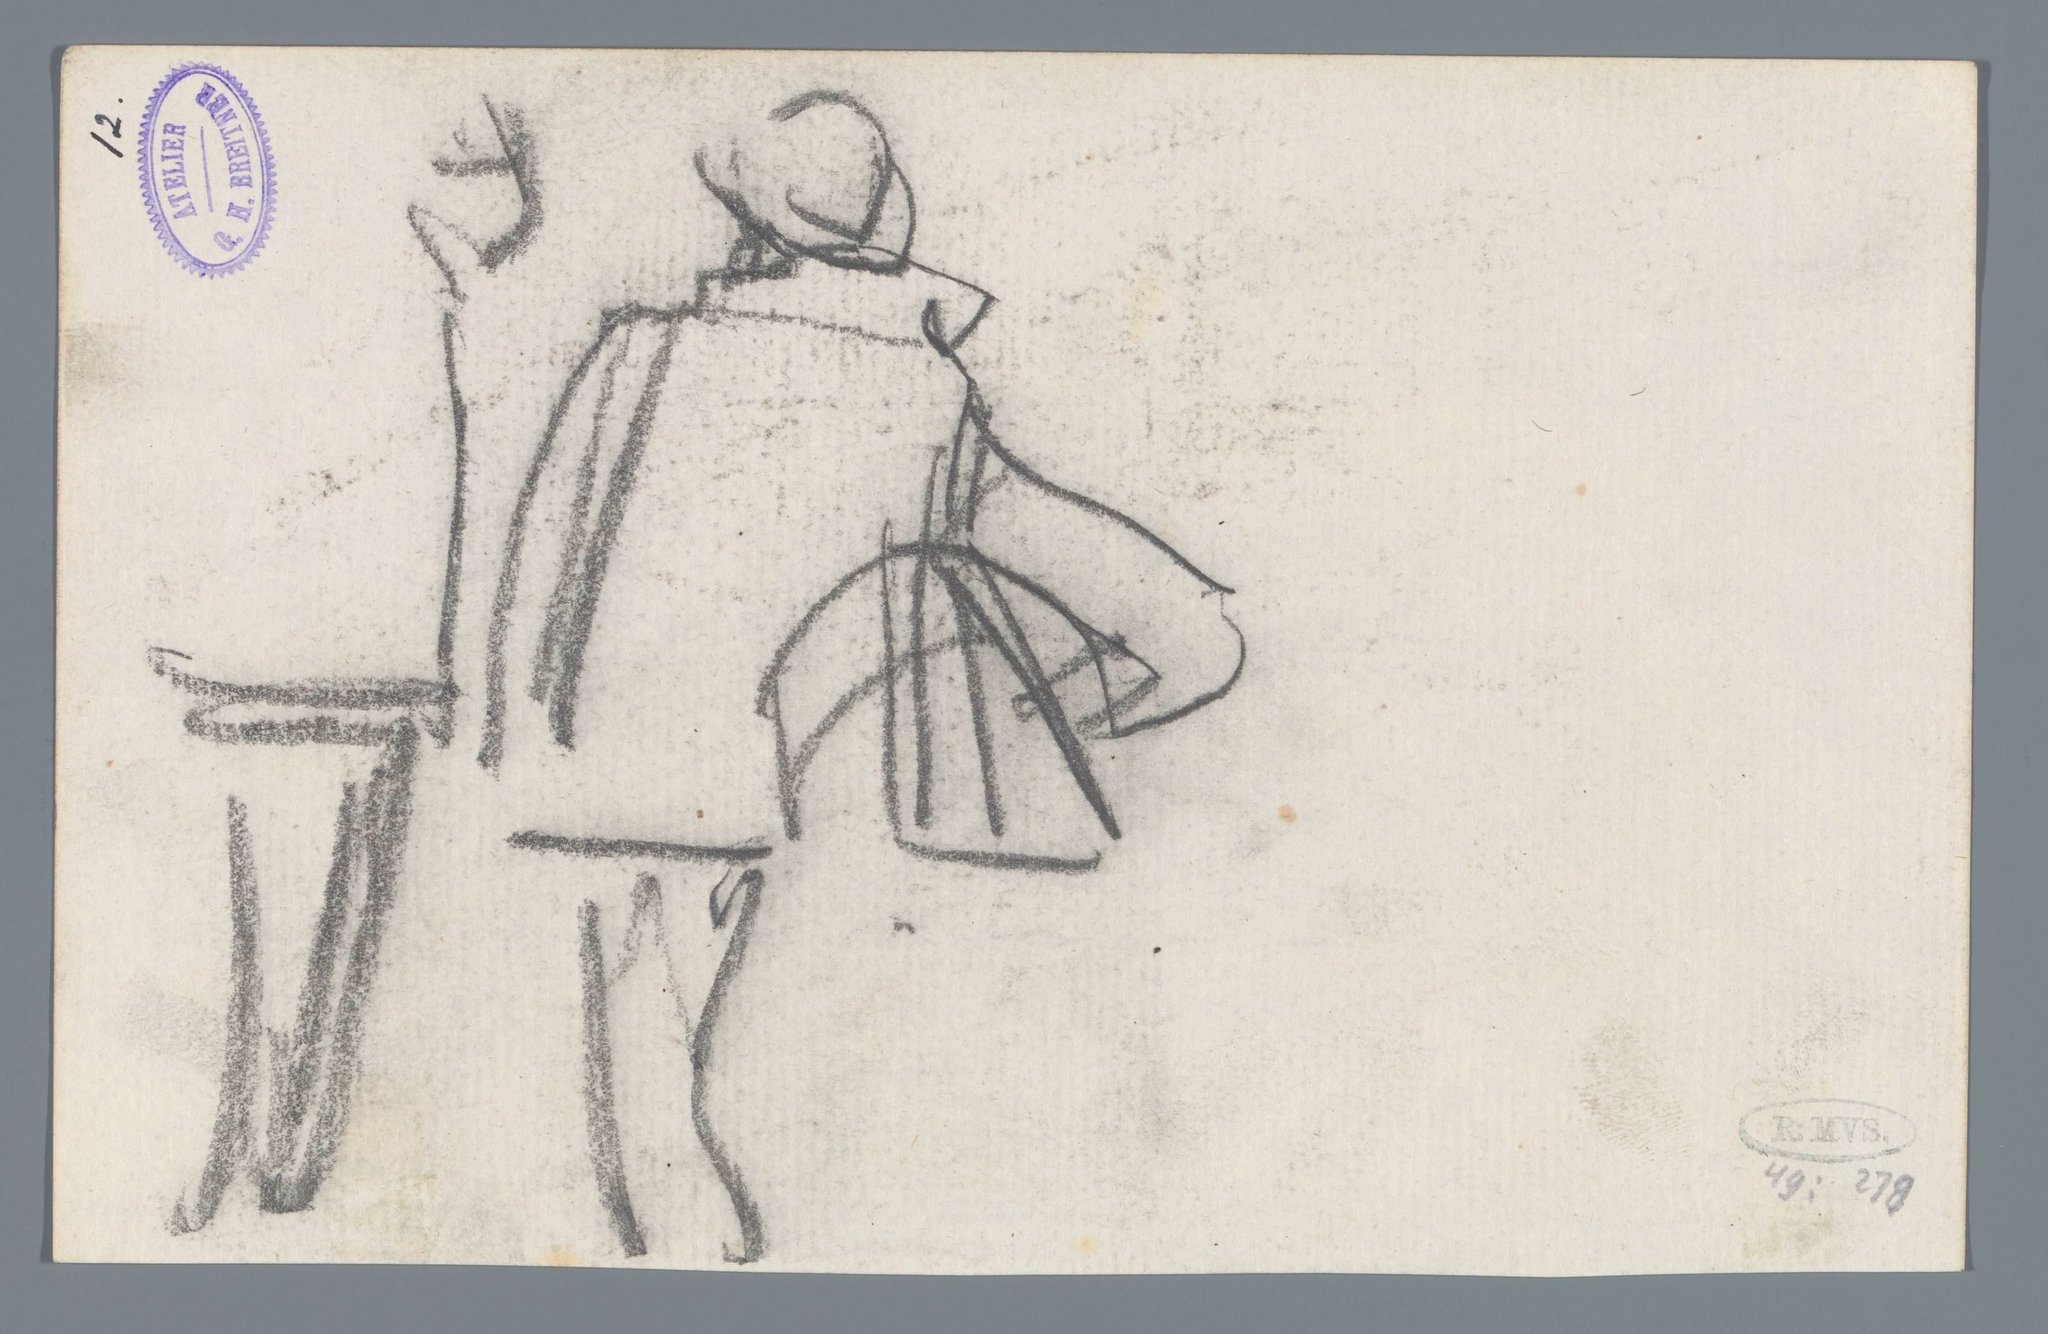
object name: drawing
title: Twee staande figuren, mogelijk mannen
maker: george hendrik breitner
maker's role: draughtsman, painter, print maker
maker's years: 1857-1923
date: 1886-1923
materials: chalk, paper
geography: amsterdam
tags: carrying something, standing figure (+ two persons)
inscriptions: collector's mark: Lugt 2228, workshop stamp: Lugt 291d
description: De rechter figuur heeft een voorwerp onder zijn arm.